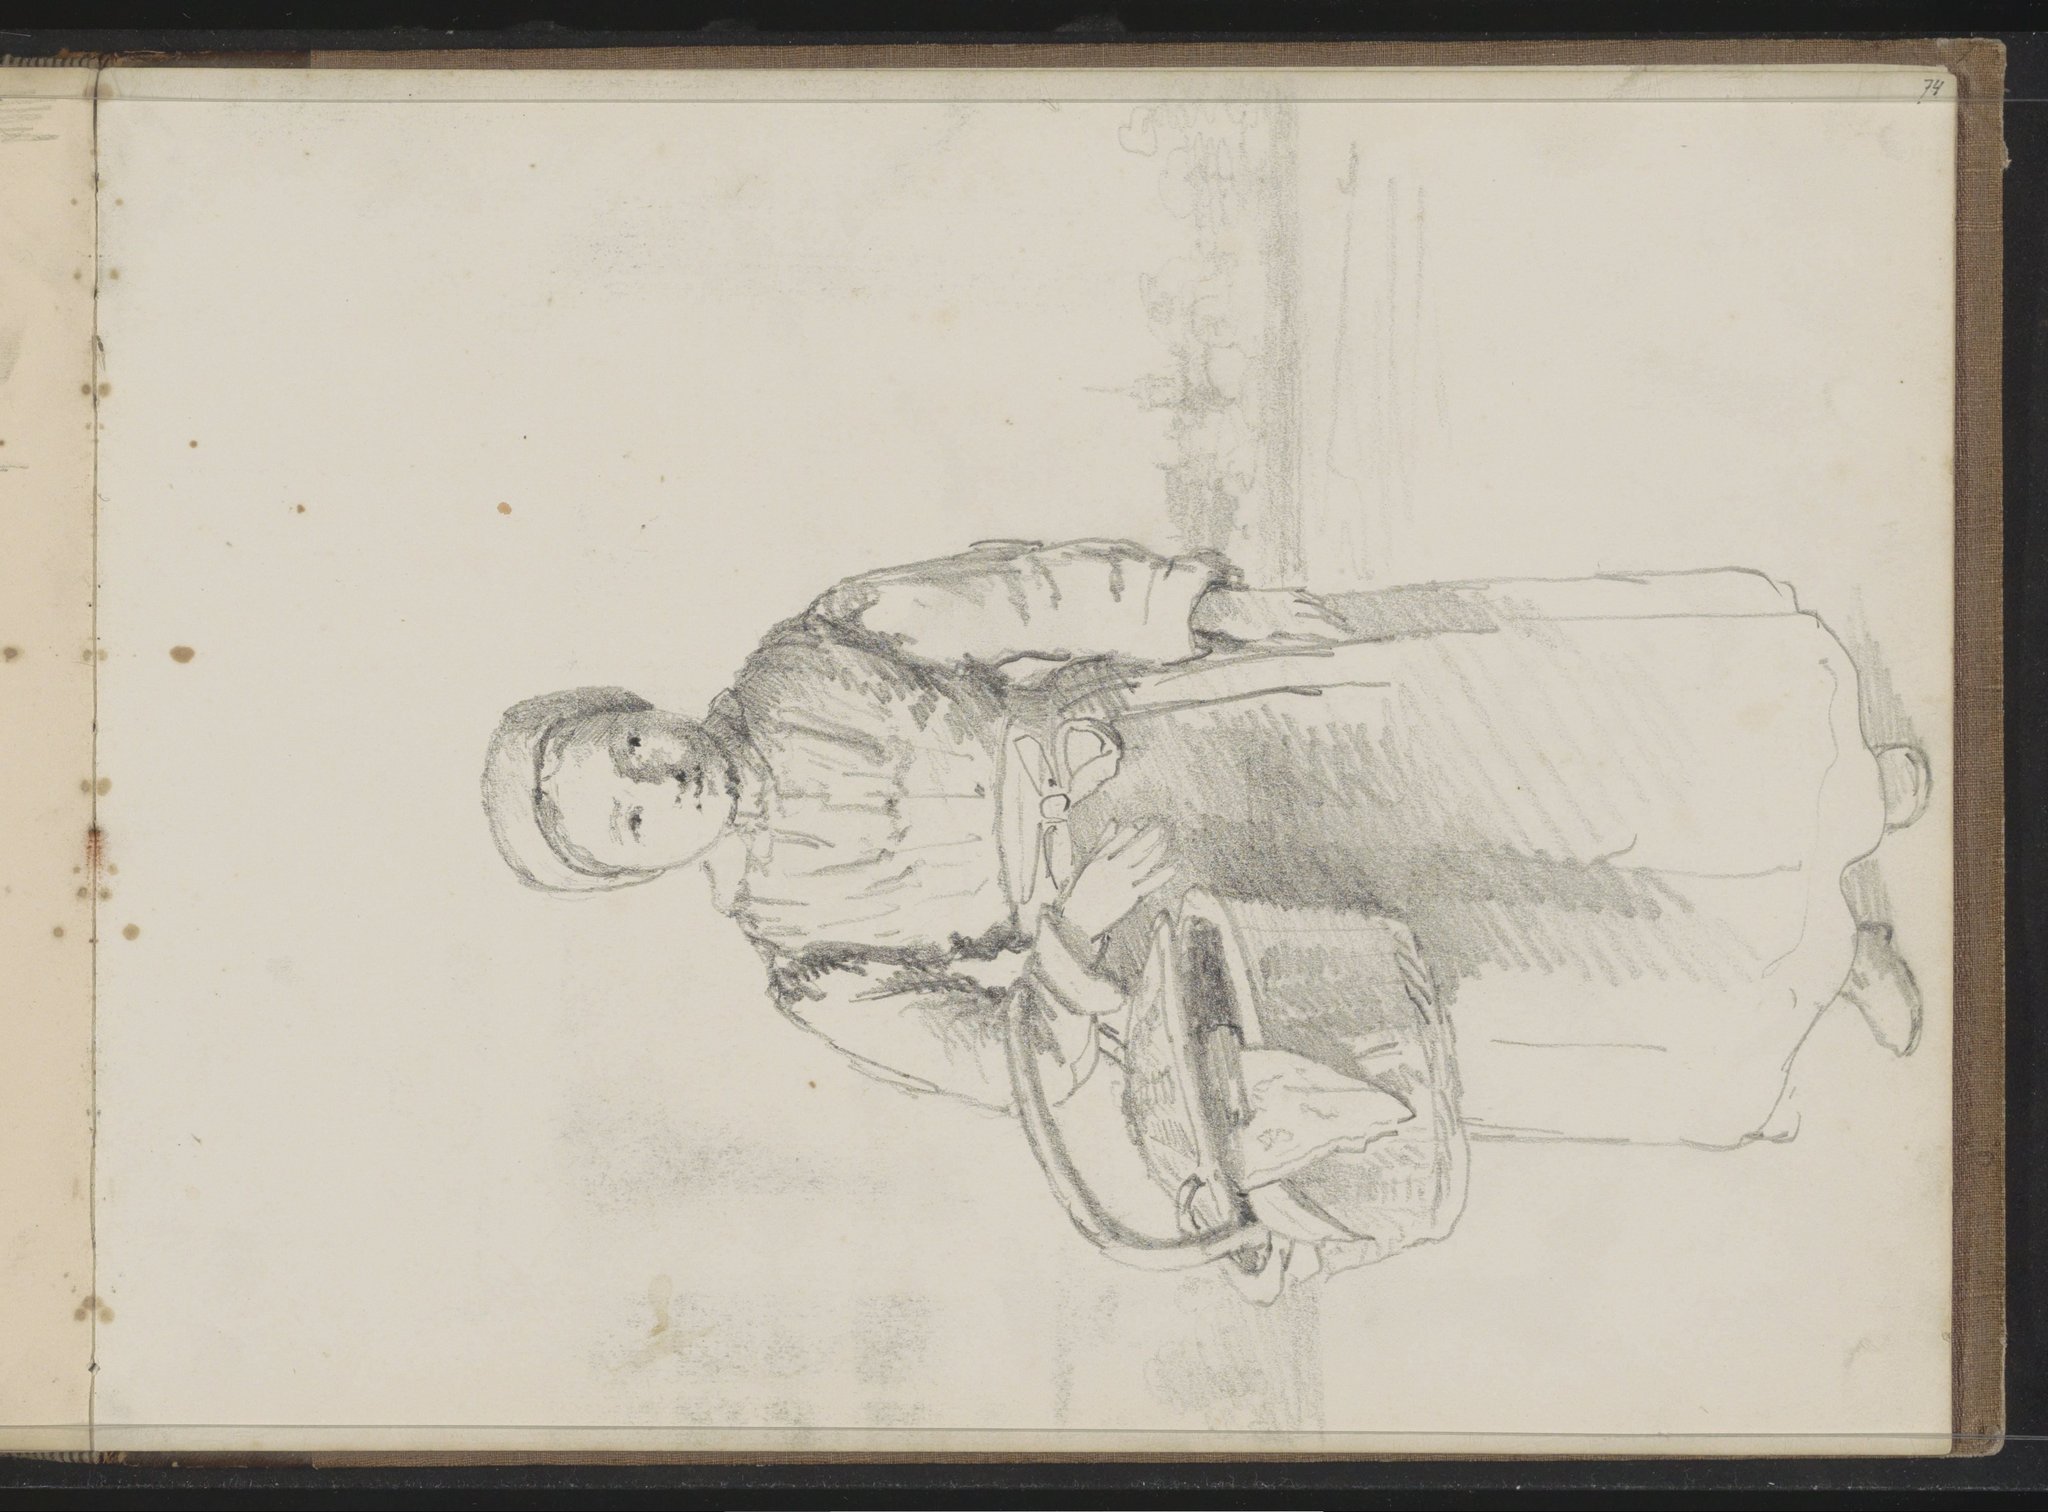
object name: sketchbook leaf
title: Boerenmeisje met een mand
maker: hendrik valkenburg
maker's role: draughtsman, painter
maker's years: 1826-1896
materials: paper, pencil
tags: carrying something in basket, bag, rucksack, etc., girl (child between toddler and youth)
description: Blad 74 recto uit een schetsboek met 77 bladen.